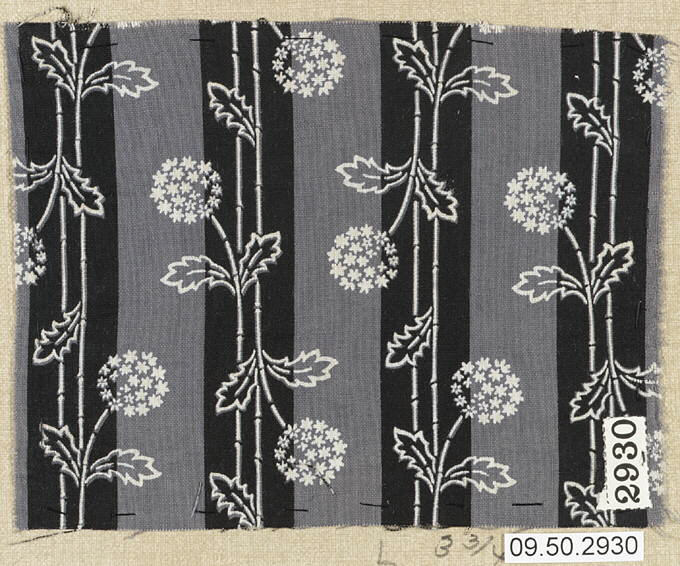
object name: piece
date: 1801-1900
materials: cotton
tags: flowers,leaves